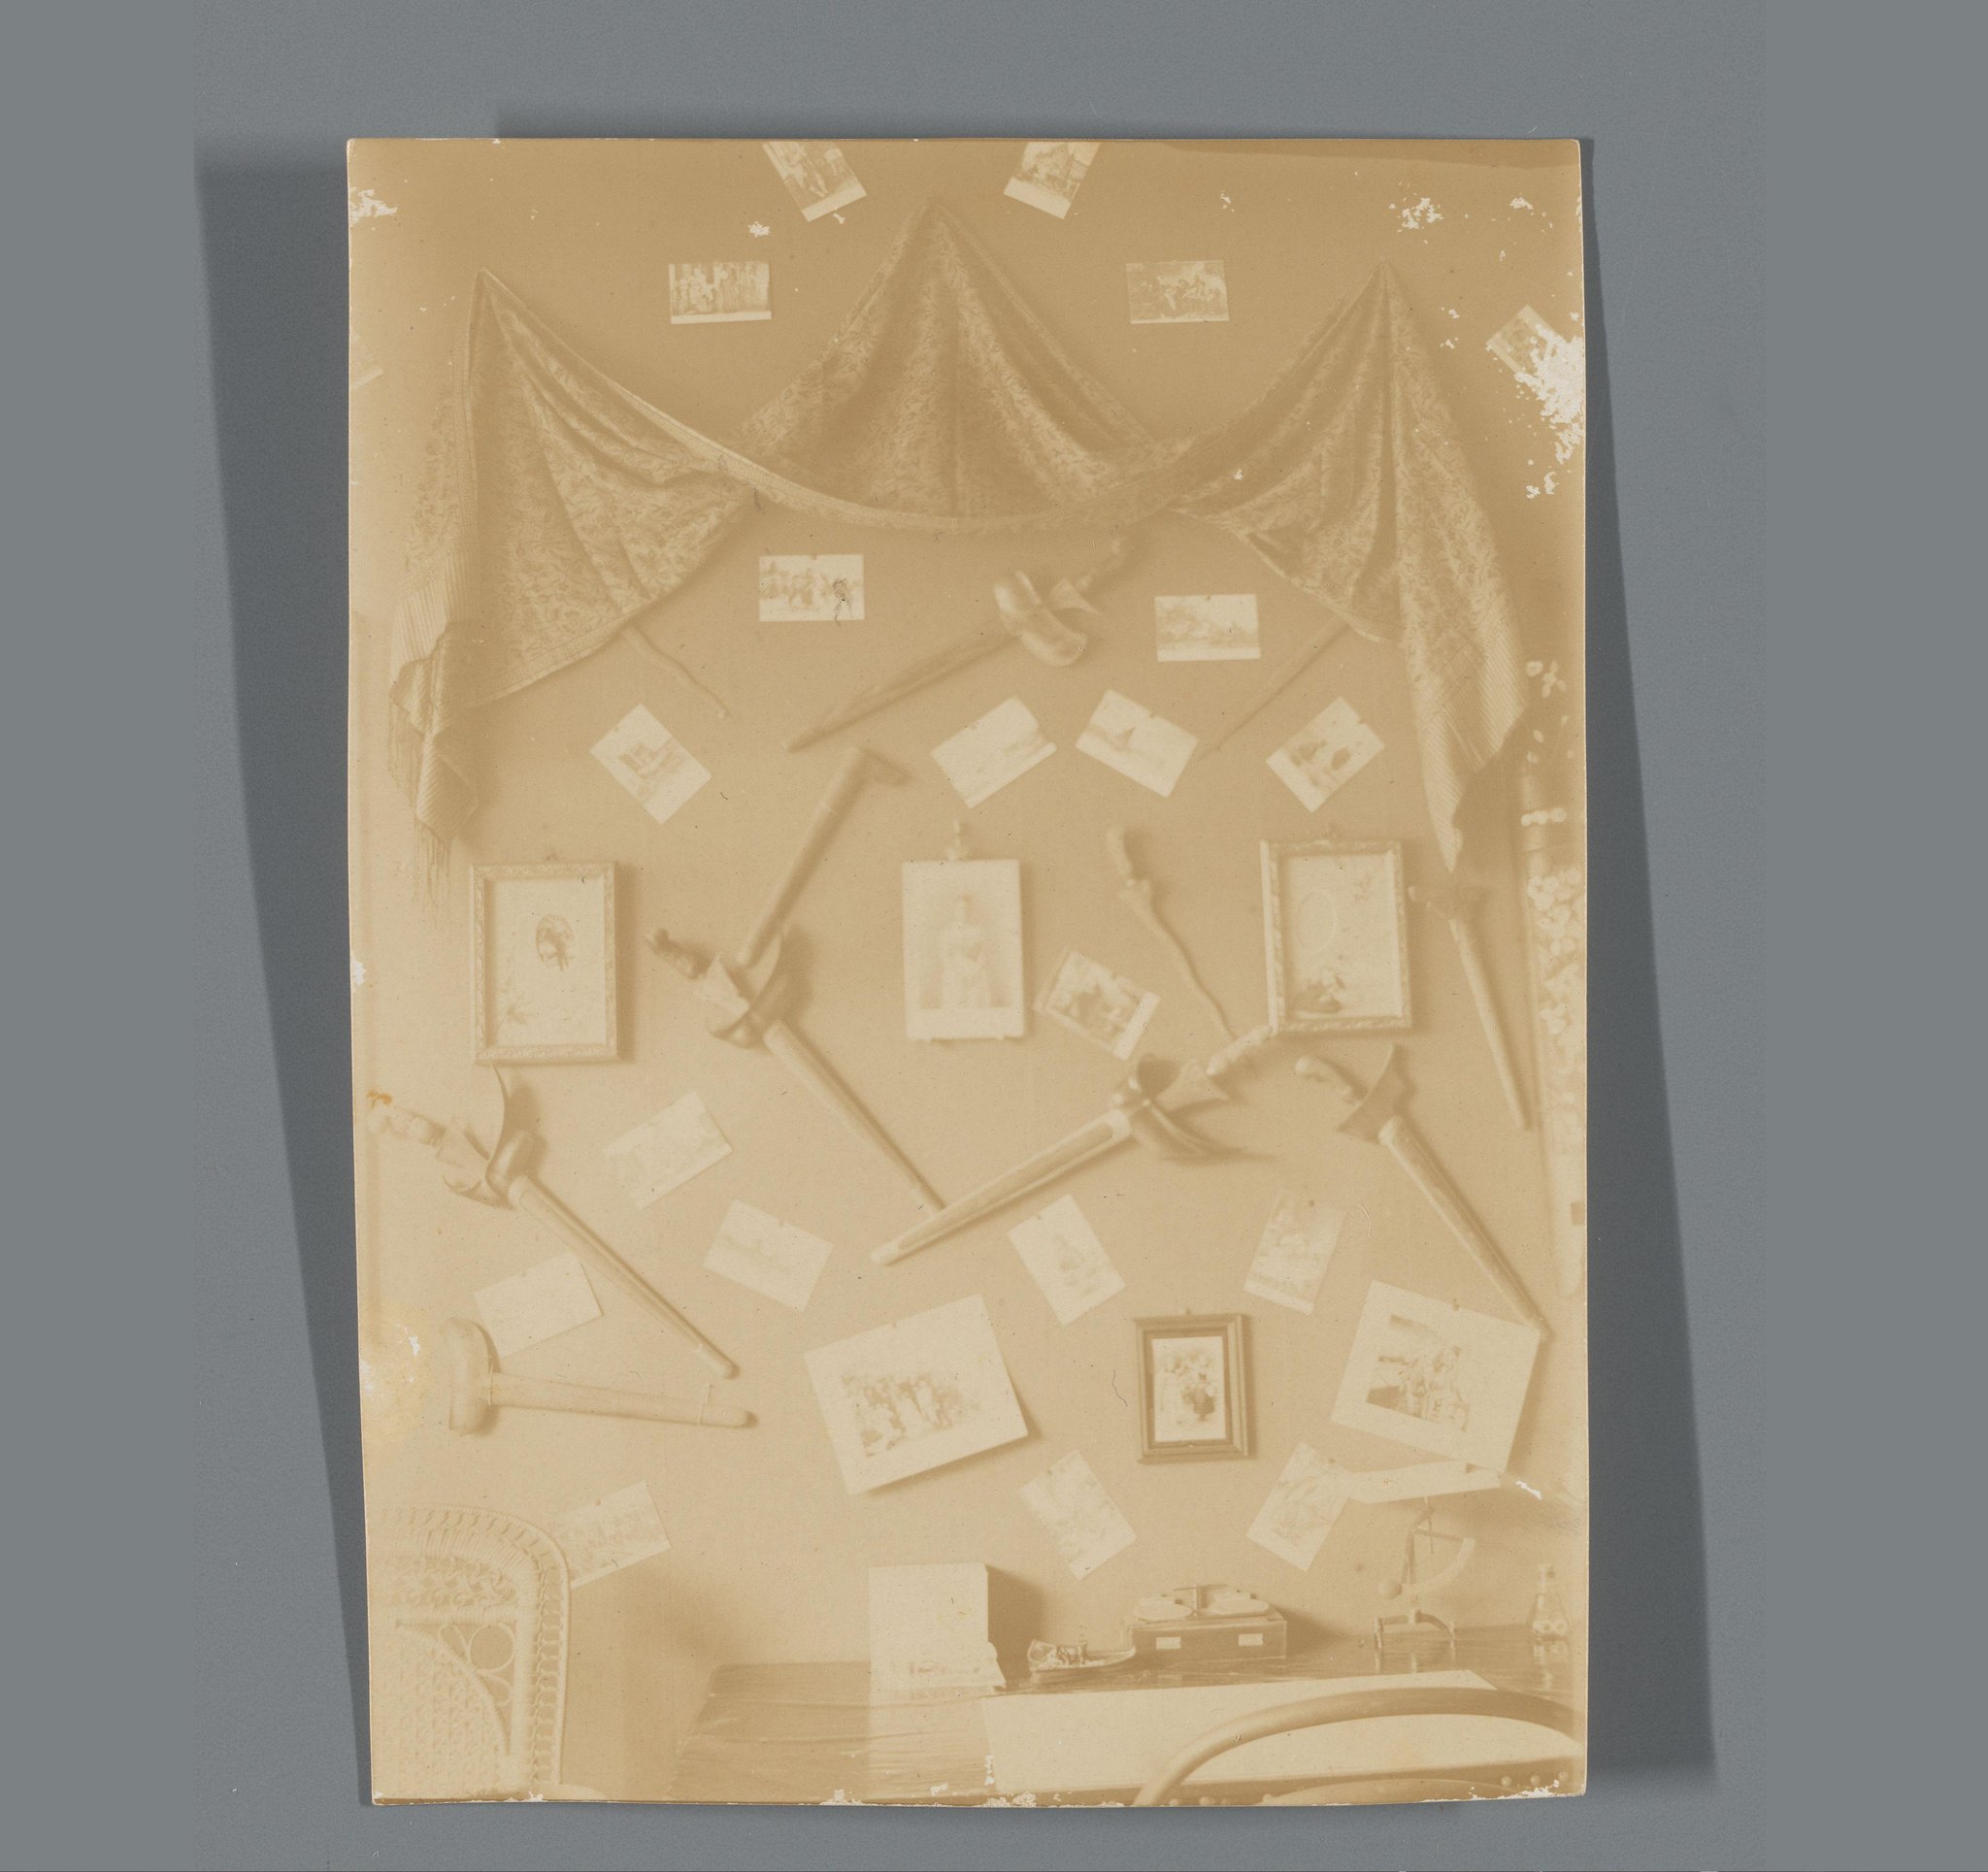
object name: photograph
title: Studentenkamer van Frédéric Gabriël Dumas met bureau en muurdecoraties, krissen en foto's (onder andere van koningin Wilhelmina)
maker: frédéric gabriël dumas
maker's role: engineer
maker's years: 1886-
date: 1904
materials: cardboard, photographic support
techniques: gelatin silver print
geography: the hague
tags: surabaya, frédéric gabriël dumas, university, study; 'studiolo'; library, student life, the hague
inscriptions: annotation: ‘voor Guus 28 augustus 1904 Den Haag Stephensonstraat 28’